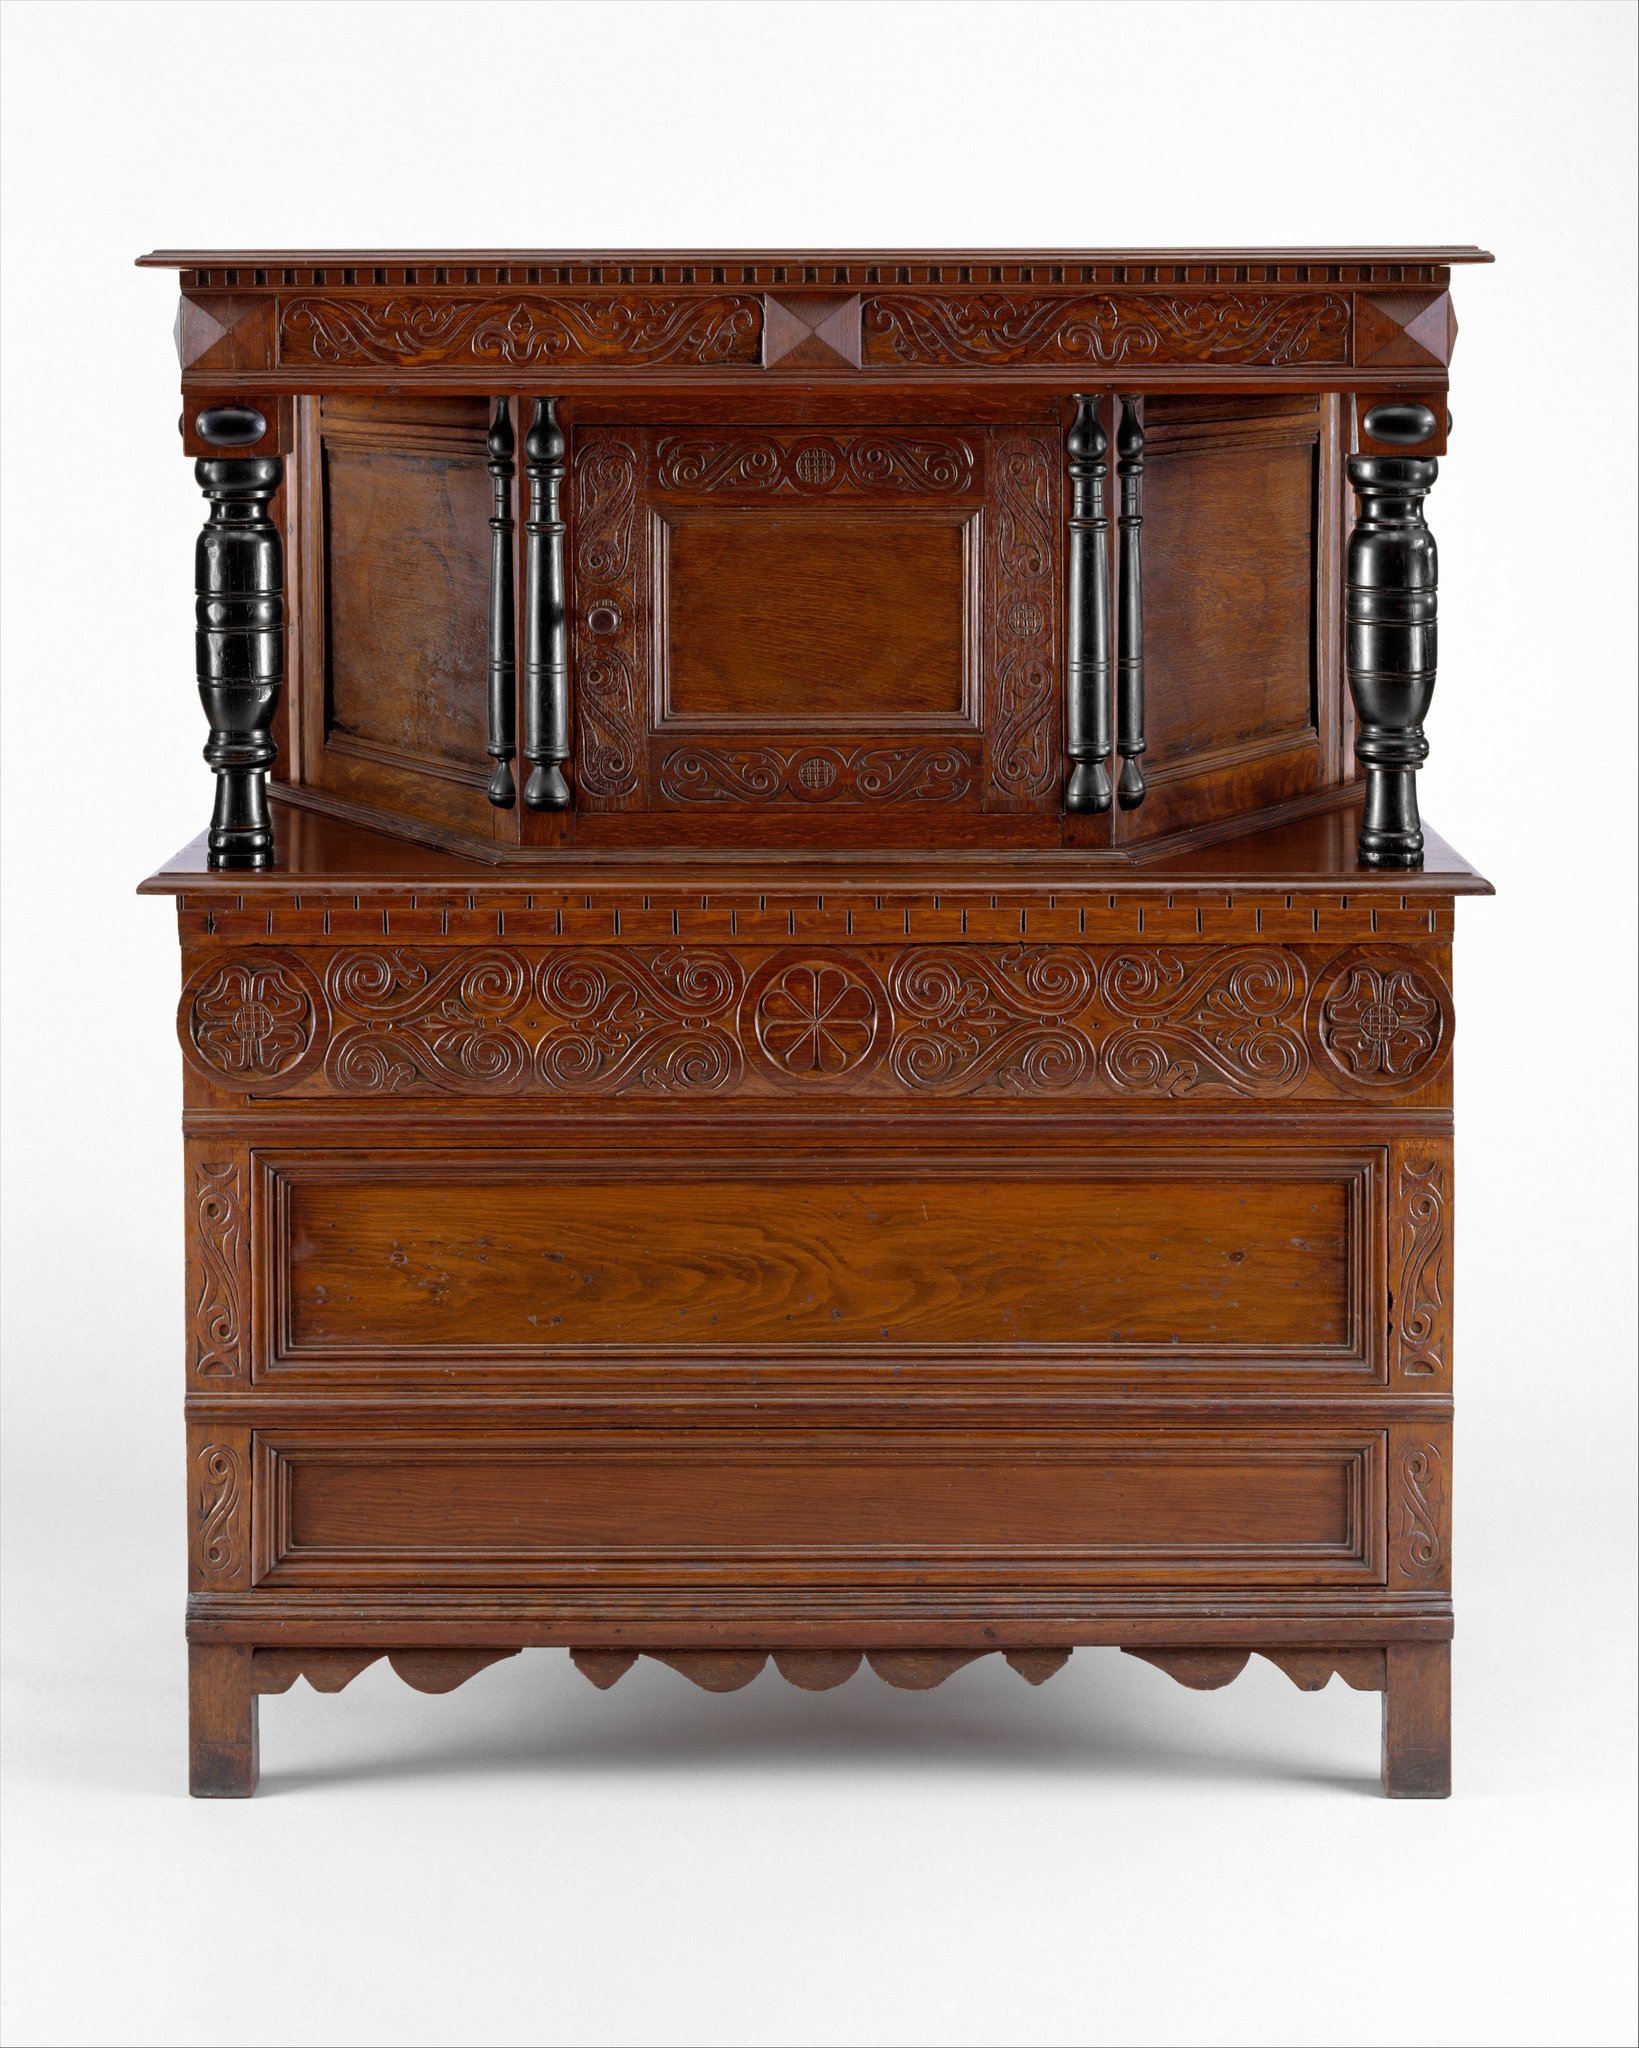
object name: cupboard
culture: american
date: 1675-1700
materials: wood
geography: united states